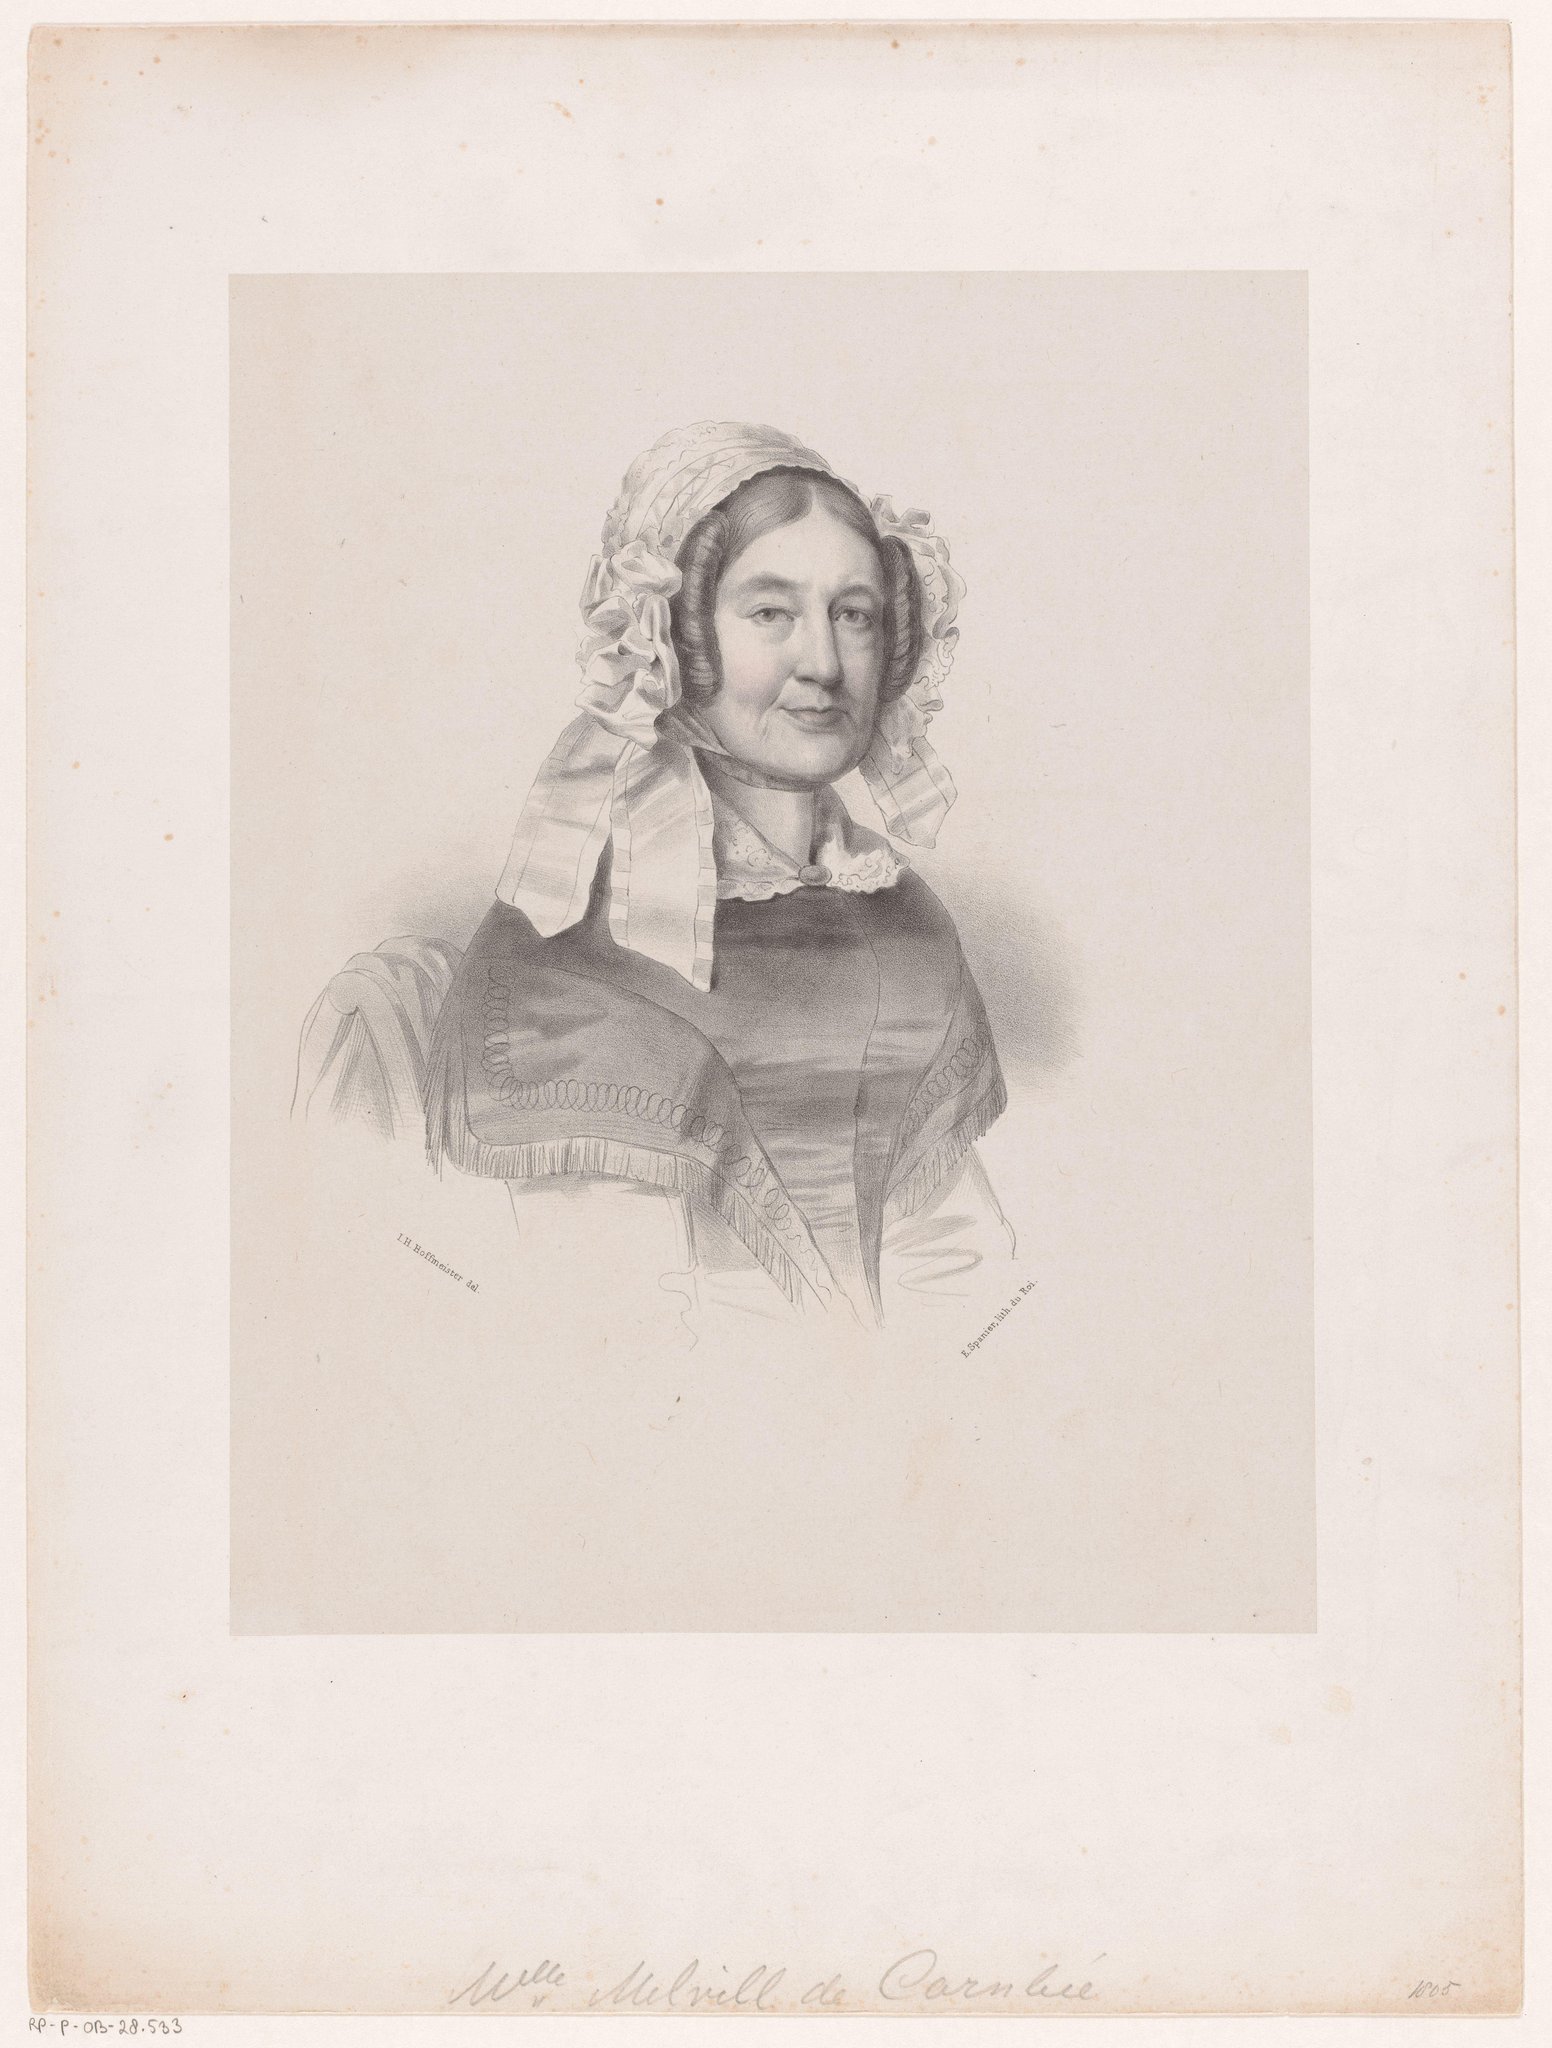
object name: print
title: Portret van mevrouw Melvill van Carnbee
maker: johan hendrik hoffmeister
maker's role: print maker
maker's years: 1823-1904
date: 1851-1883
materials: paper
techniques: lithograph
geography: the hague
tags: historical persons - bb - woman (+ (full) bust portrait), cape: mantelet (+ women's clothes), head-gear: cap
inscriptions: collector's mark: Lugt 2228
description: De geportretteerde draagt een muts met linten en een stola